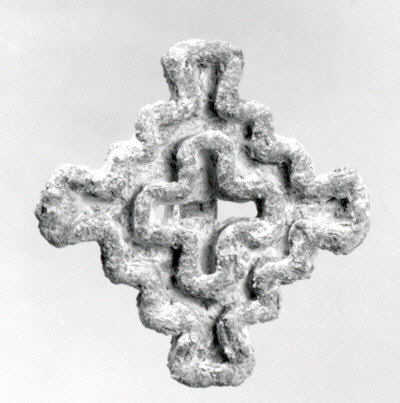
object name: stamp seal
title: Compartmented stamp seal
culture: bactria-margiana archaeological complex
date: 2333-1668 BCE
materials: copper alloy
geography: bactria-margiana